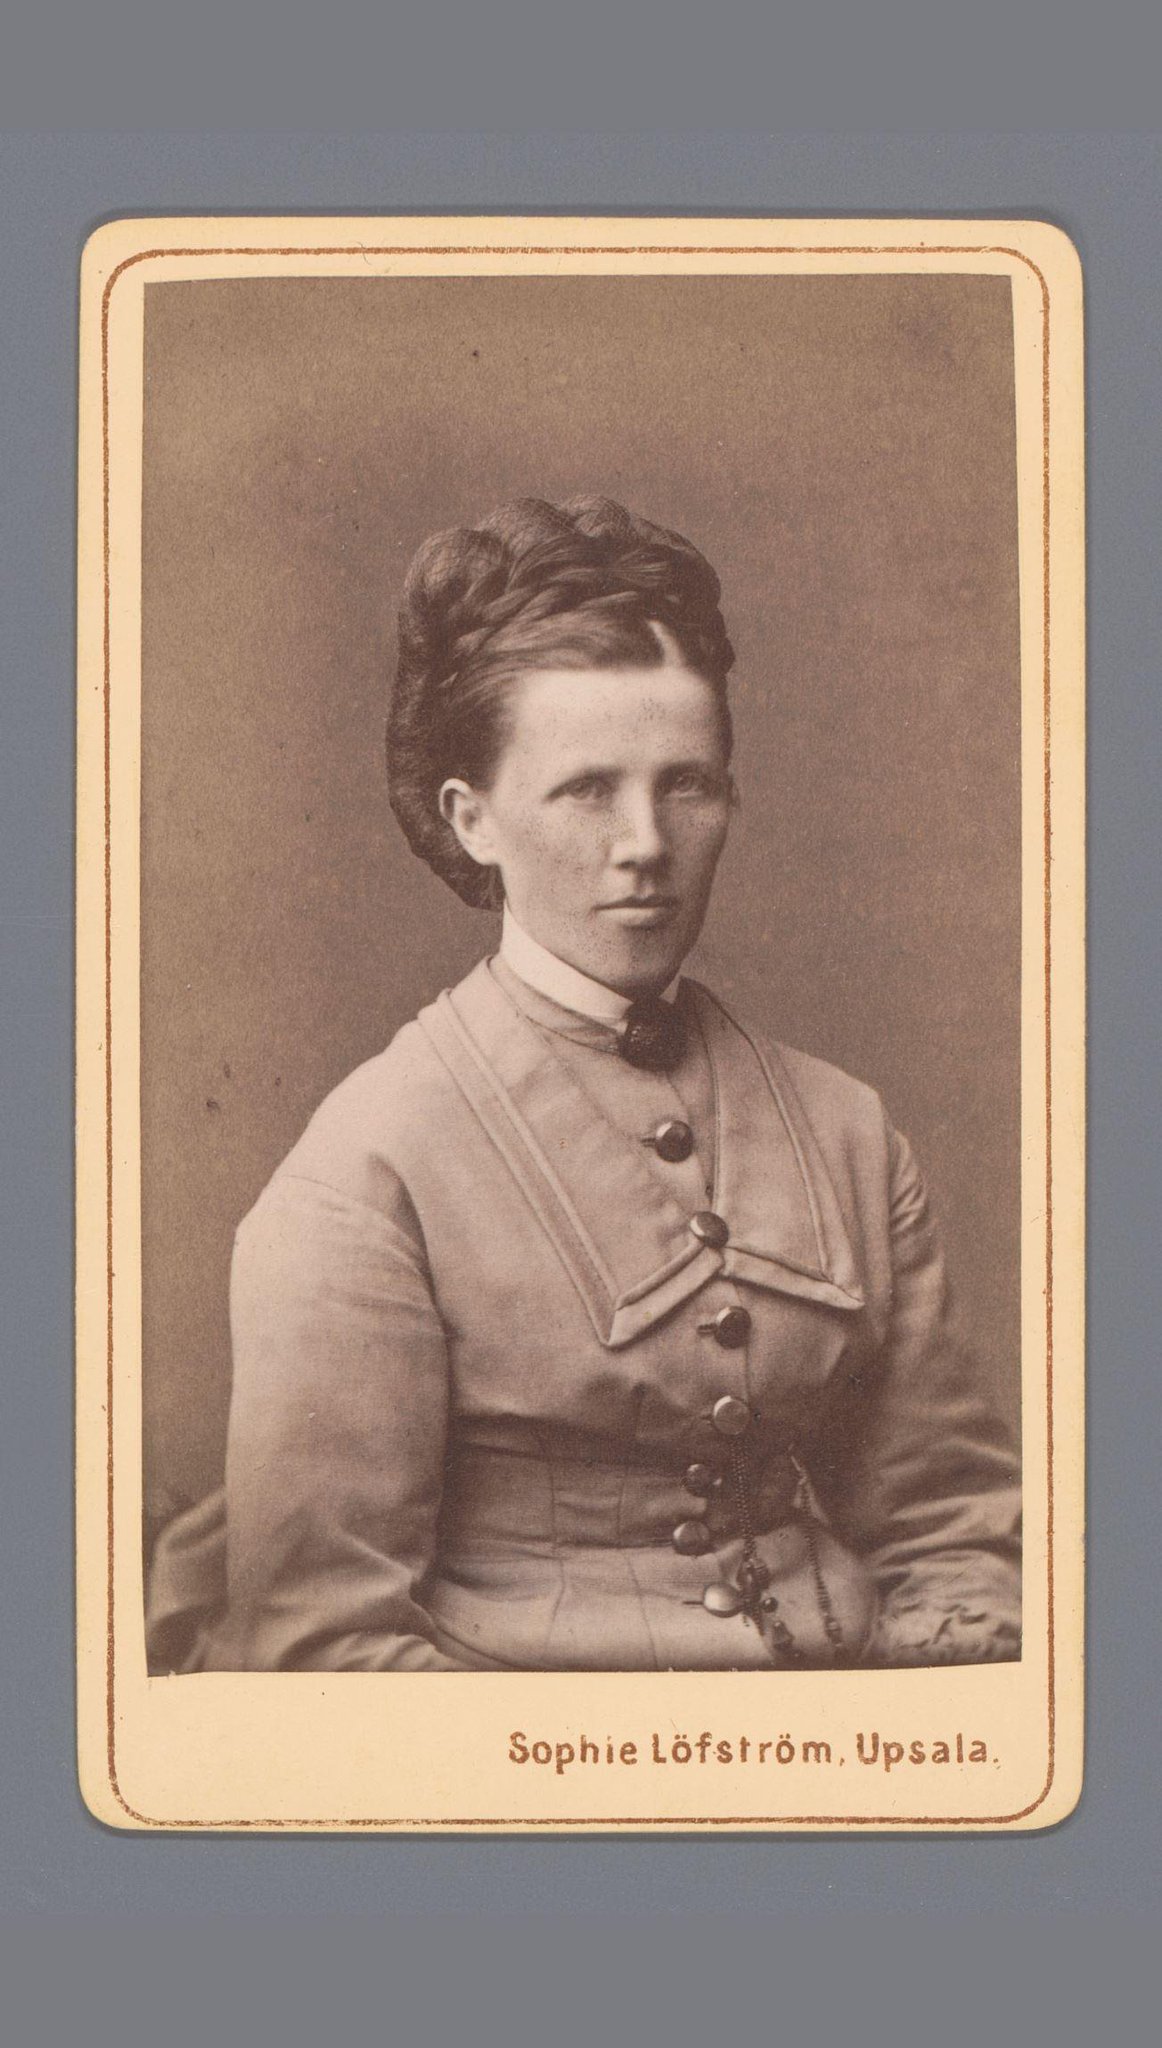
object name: photograph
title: Portret van een onbekende vrouw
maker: sophie löfström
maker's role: fotograaf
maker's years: 1835-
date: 1873-1886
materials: cardboard, paper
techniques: albumen print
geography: uppsala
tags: historical persons - bb - woman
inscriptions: inscription: ‘Sophie Löfström/ UPSALA./ Östra Ågatan No. 17./ Plåten förvaras för efterbeställning.’